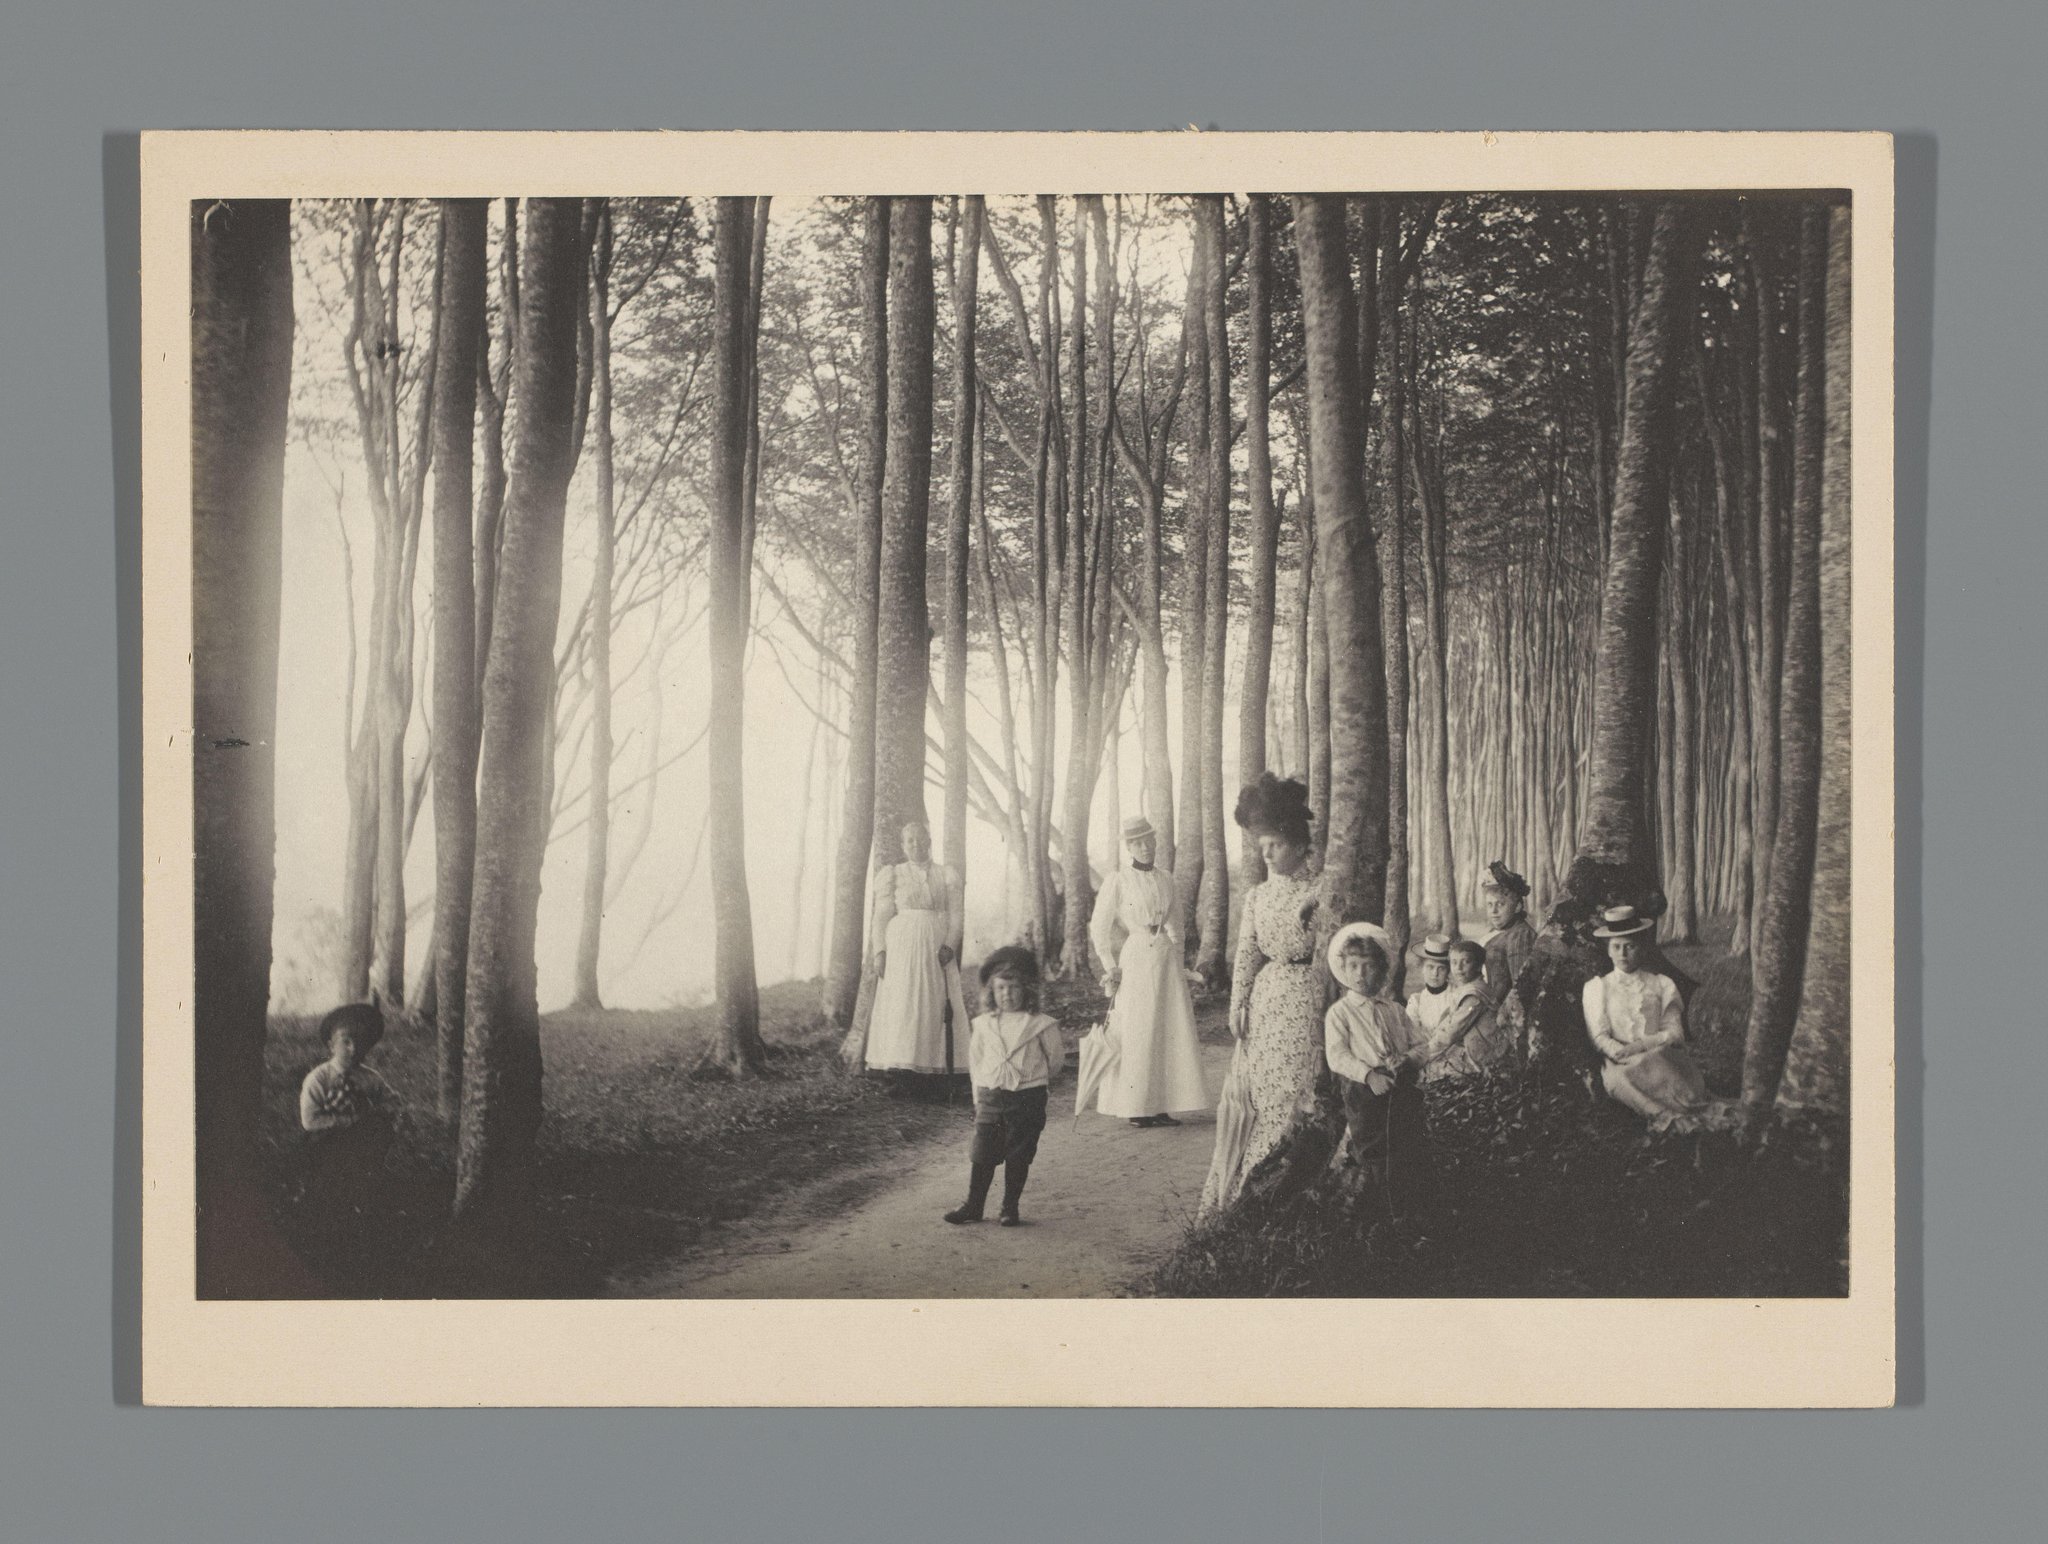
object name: photograph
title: Groepsportret in een bos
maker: Anonymous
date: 1900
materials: photographic support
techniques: gelatin silver print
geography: germany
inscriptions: inscription: ‘16 July 1900’